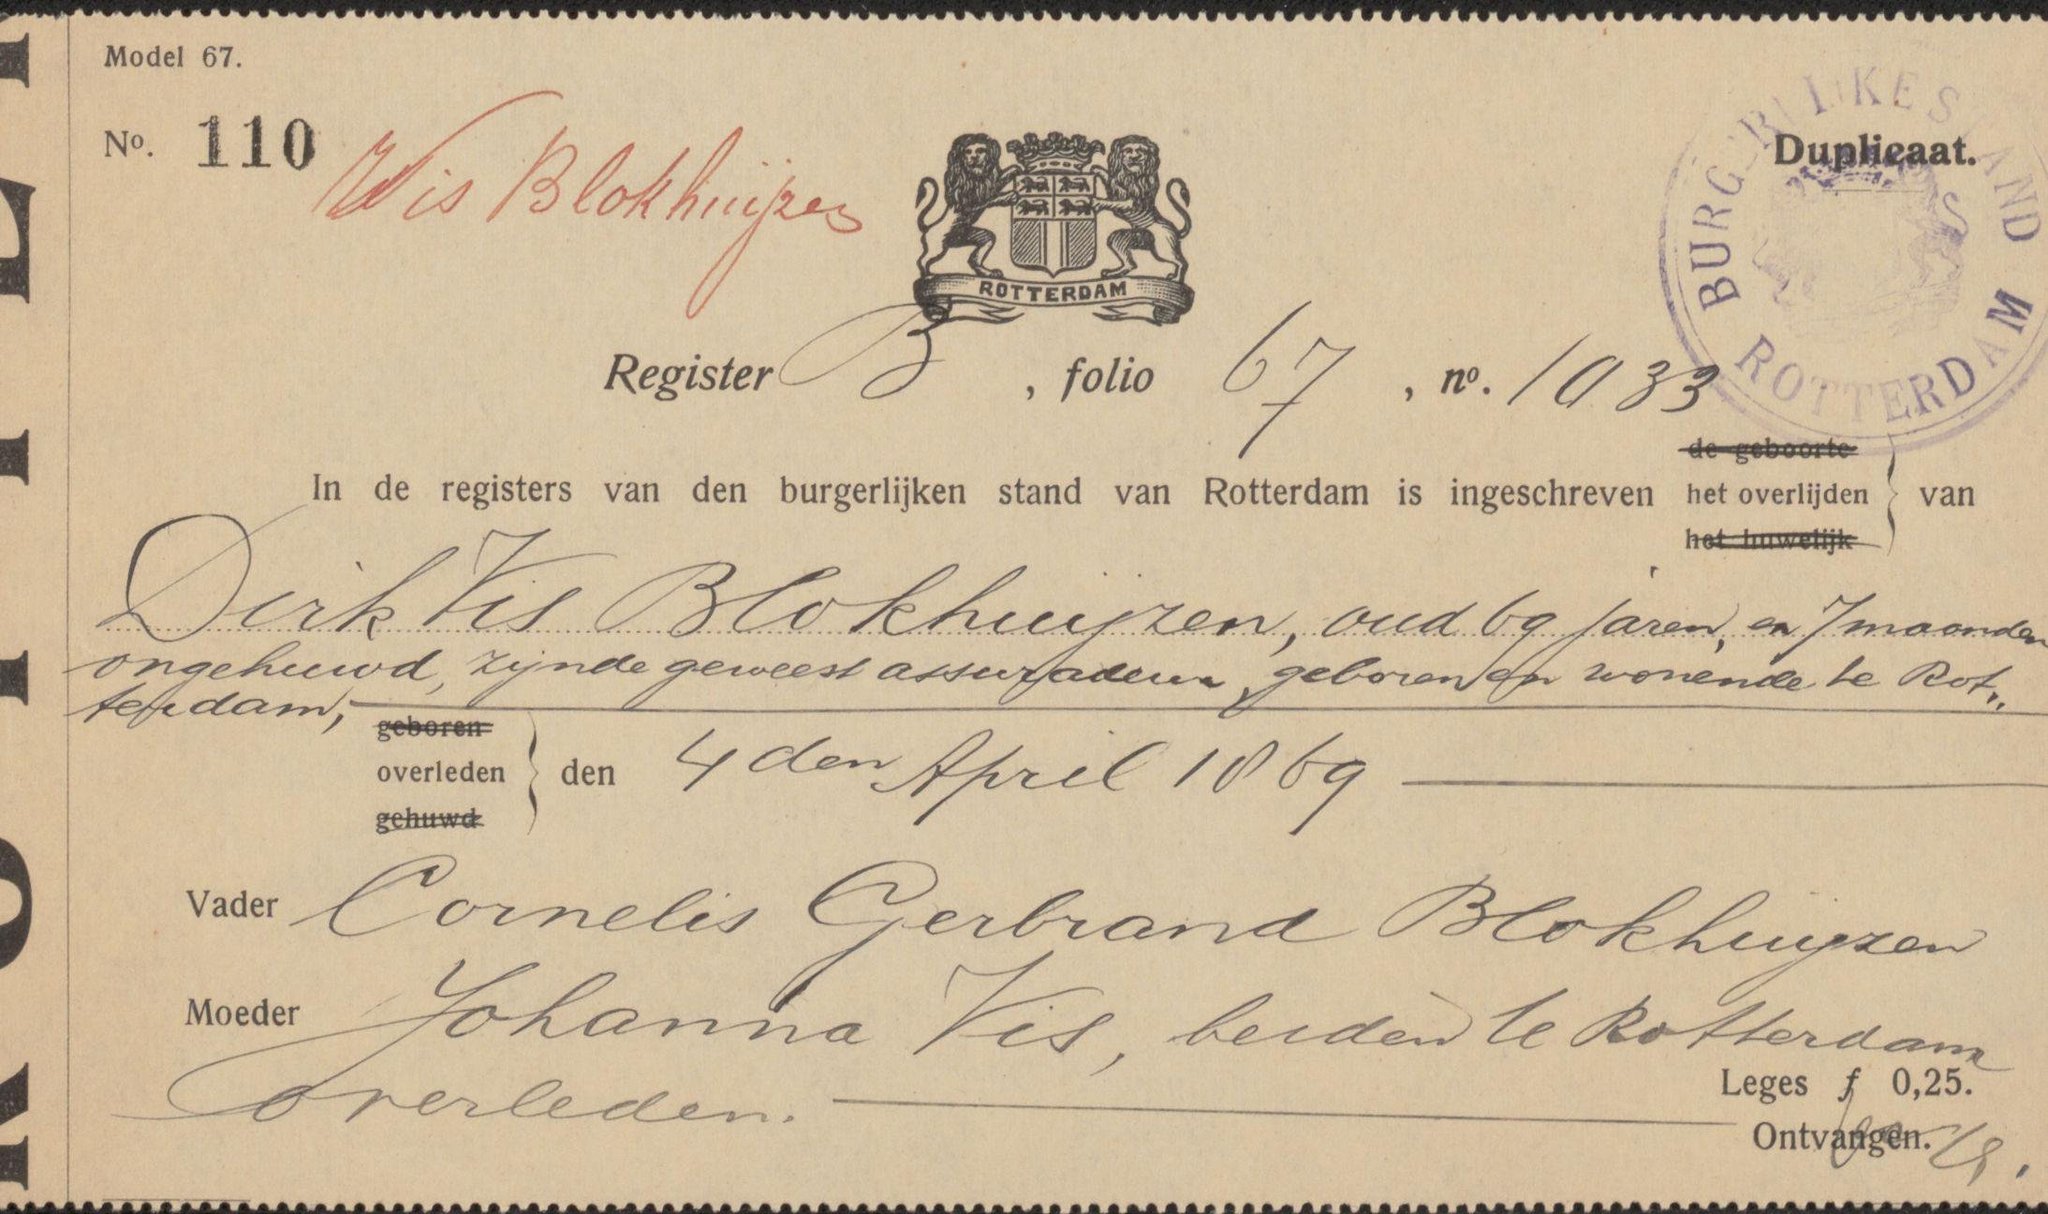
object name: document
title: Document betreffende het overlijden van Dirk Vis Blokhuyzen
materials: ink, paper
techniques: pen, printing, writing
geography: rotterdam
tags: rotterdam, print maker, dirk vis blokhuyzen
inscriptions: stamp